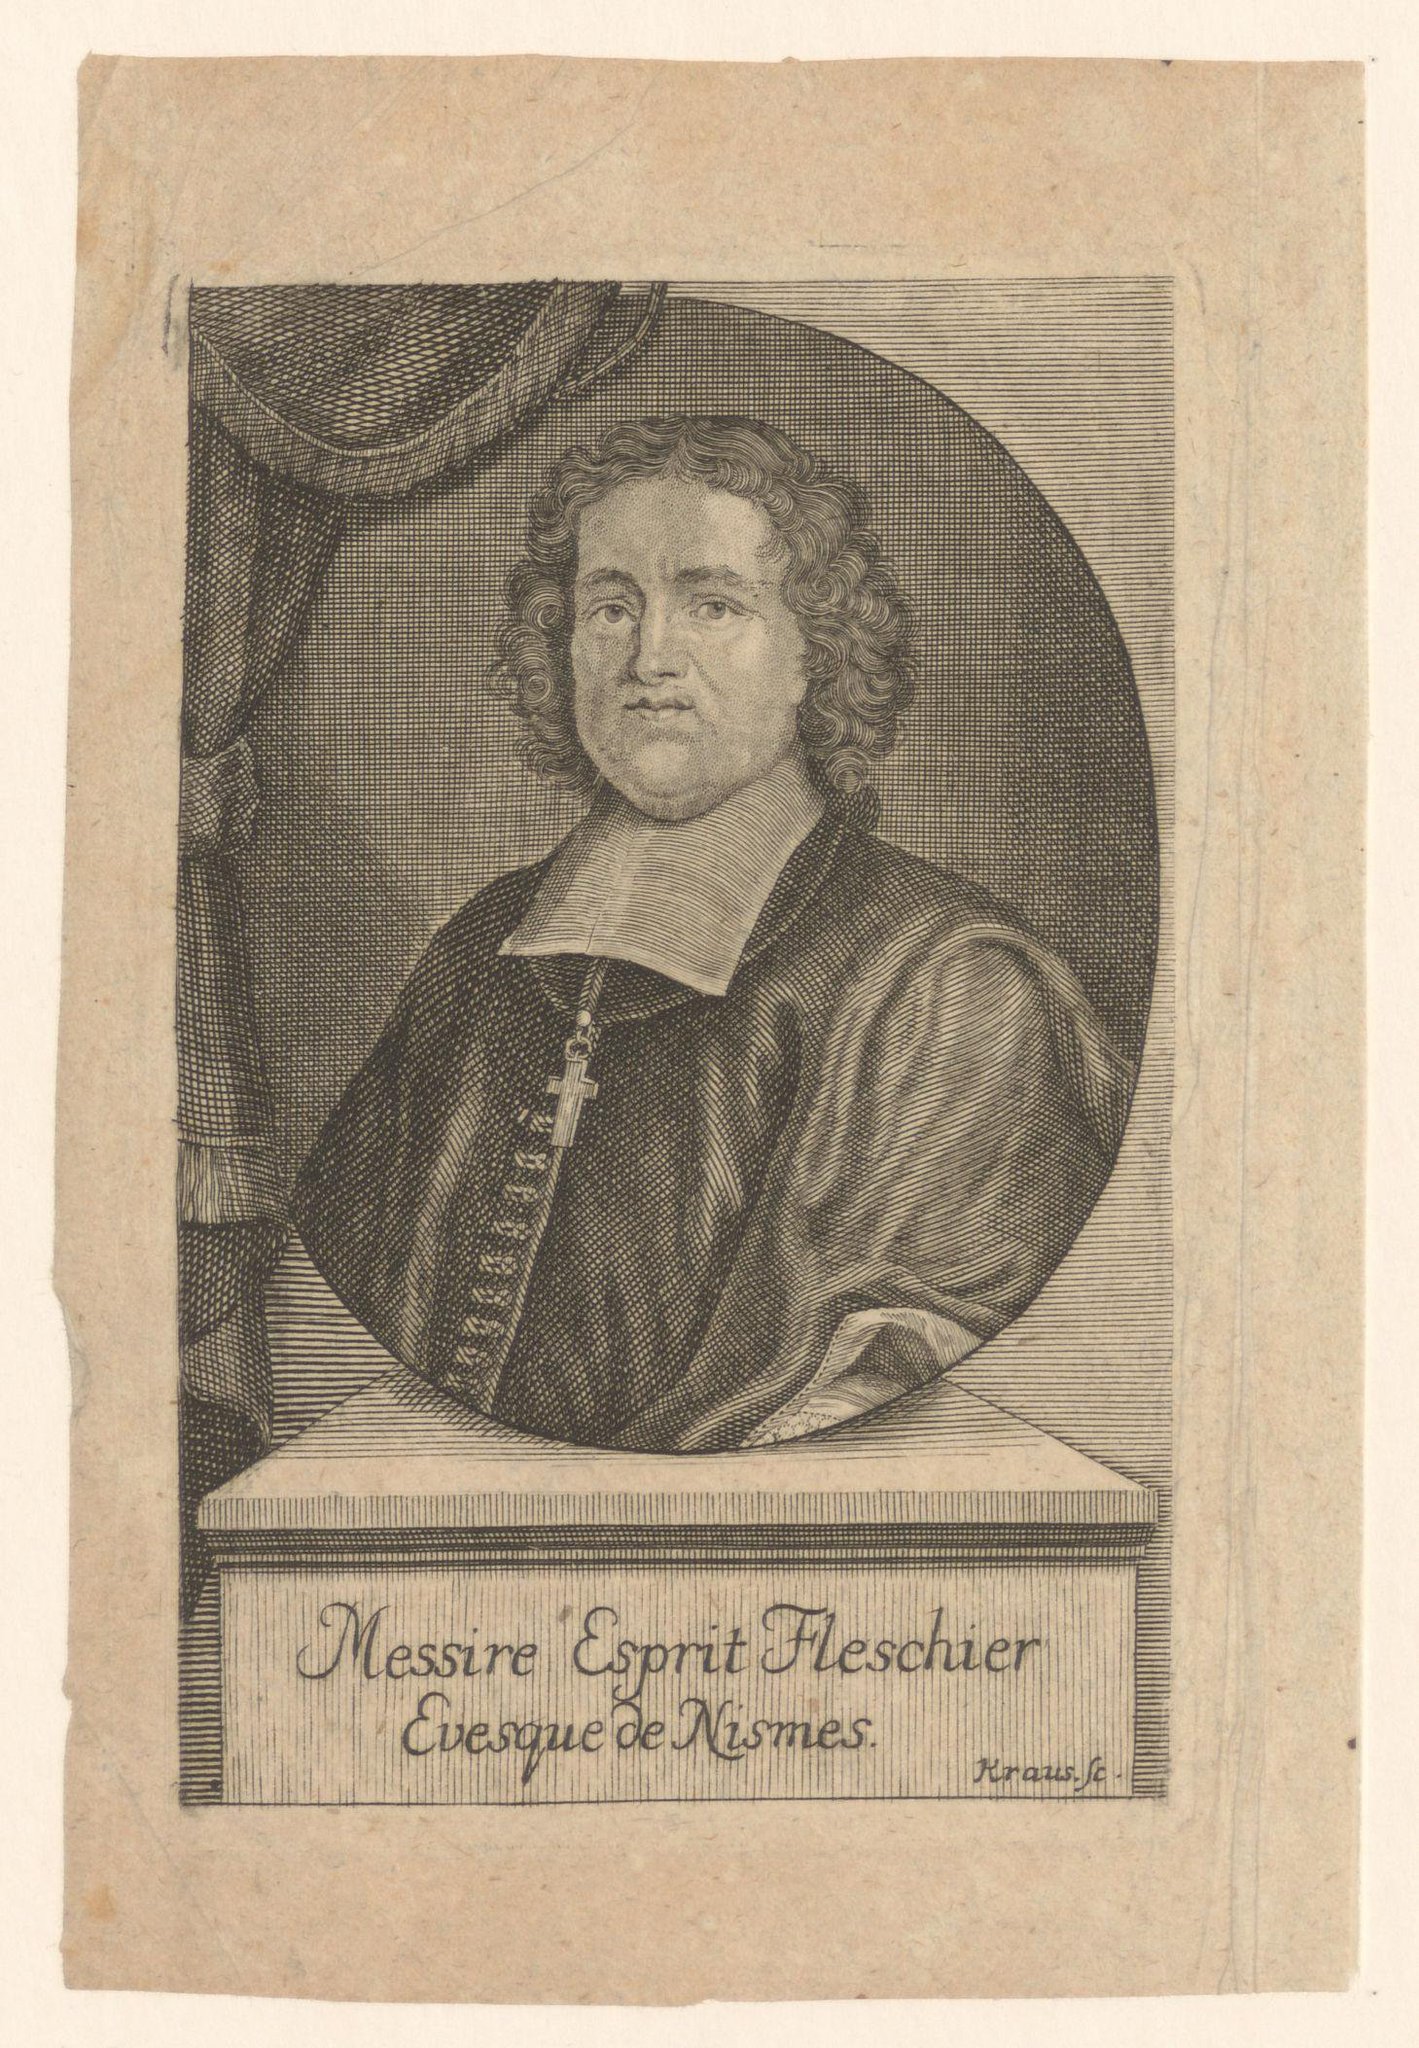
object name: print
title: Portret van Valentin-Esprit Fléchier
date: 1716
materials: paper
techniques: engraving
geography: leipzig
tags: archbishop, bishop, etc. (roman catholic), historical persons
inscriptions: collector's mark: Lugt 2228